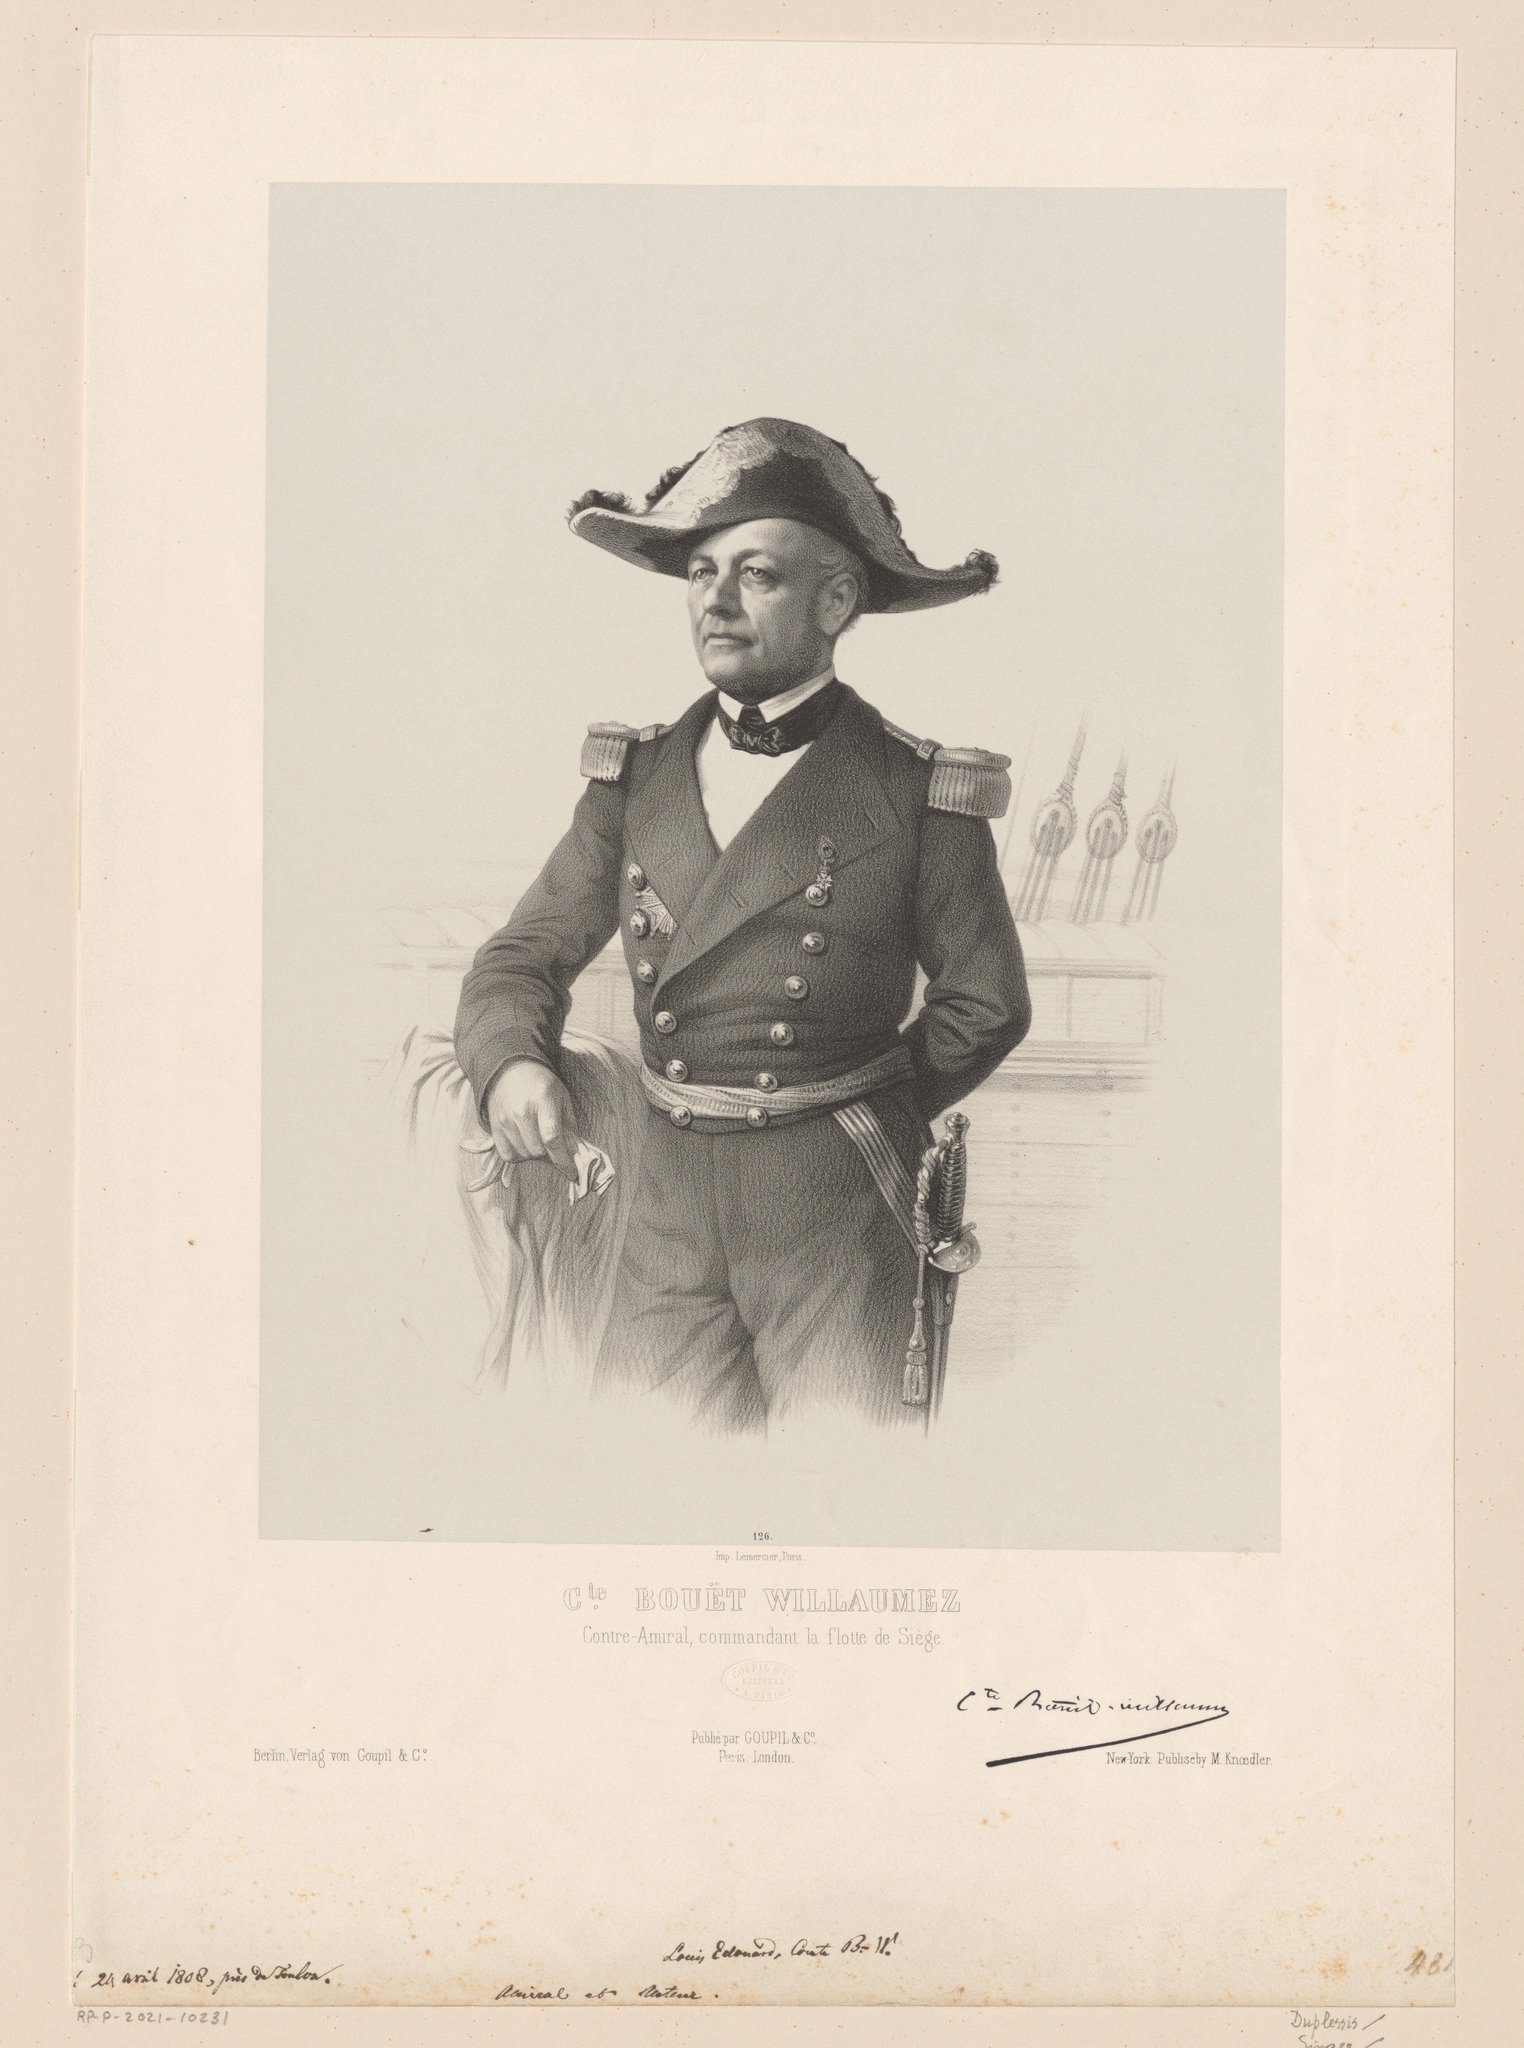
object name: print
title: Cte. Bouët Willaumez, contre-amiral, commandant le flotte de siège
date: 1857-1878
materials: paper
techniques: lithograph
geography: new york city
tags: historical persons, commander-in-chief, admiral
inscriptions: inscription: ‘24 april 1808 (...)’, workshop stamp: Lugt 1090